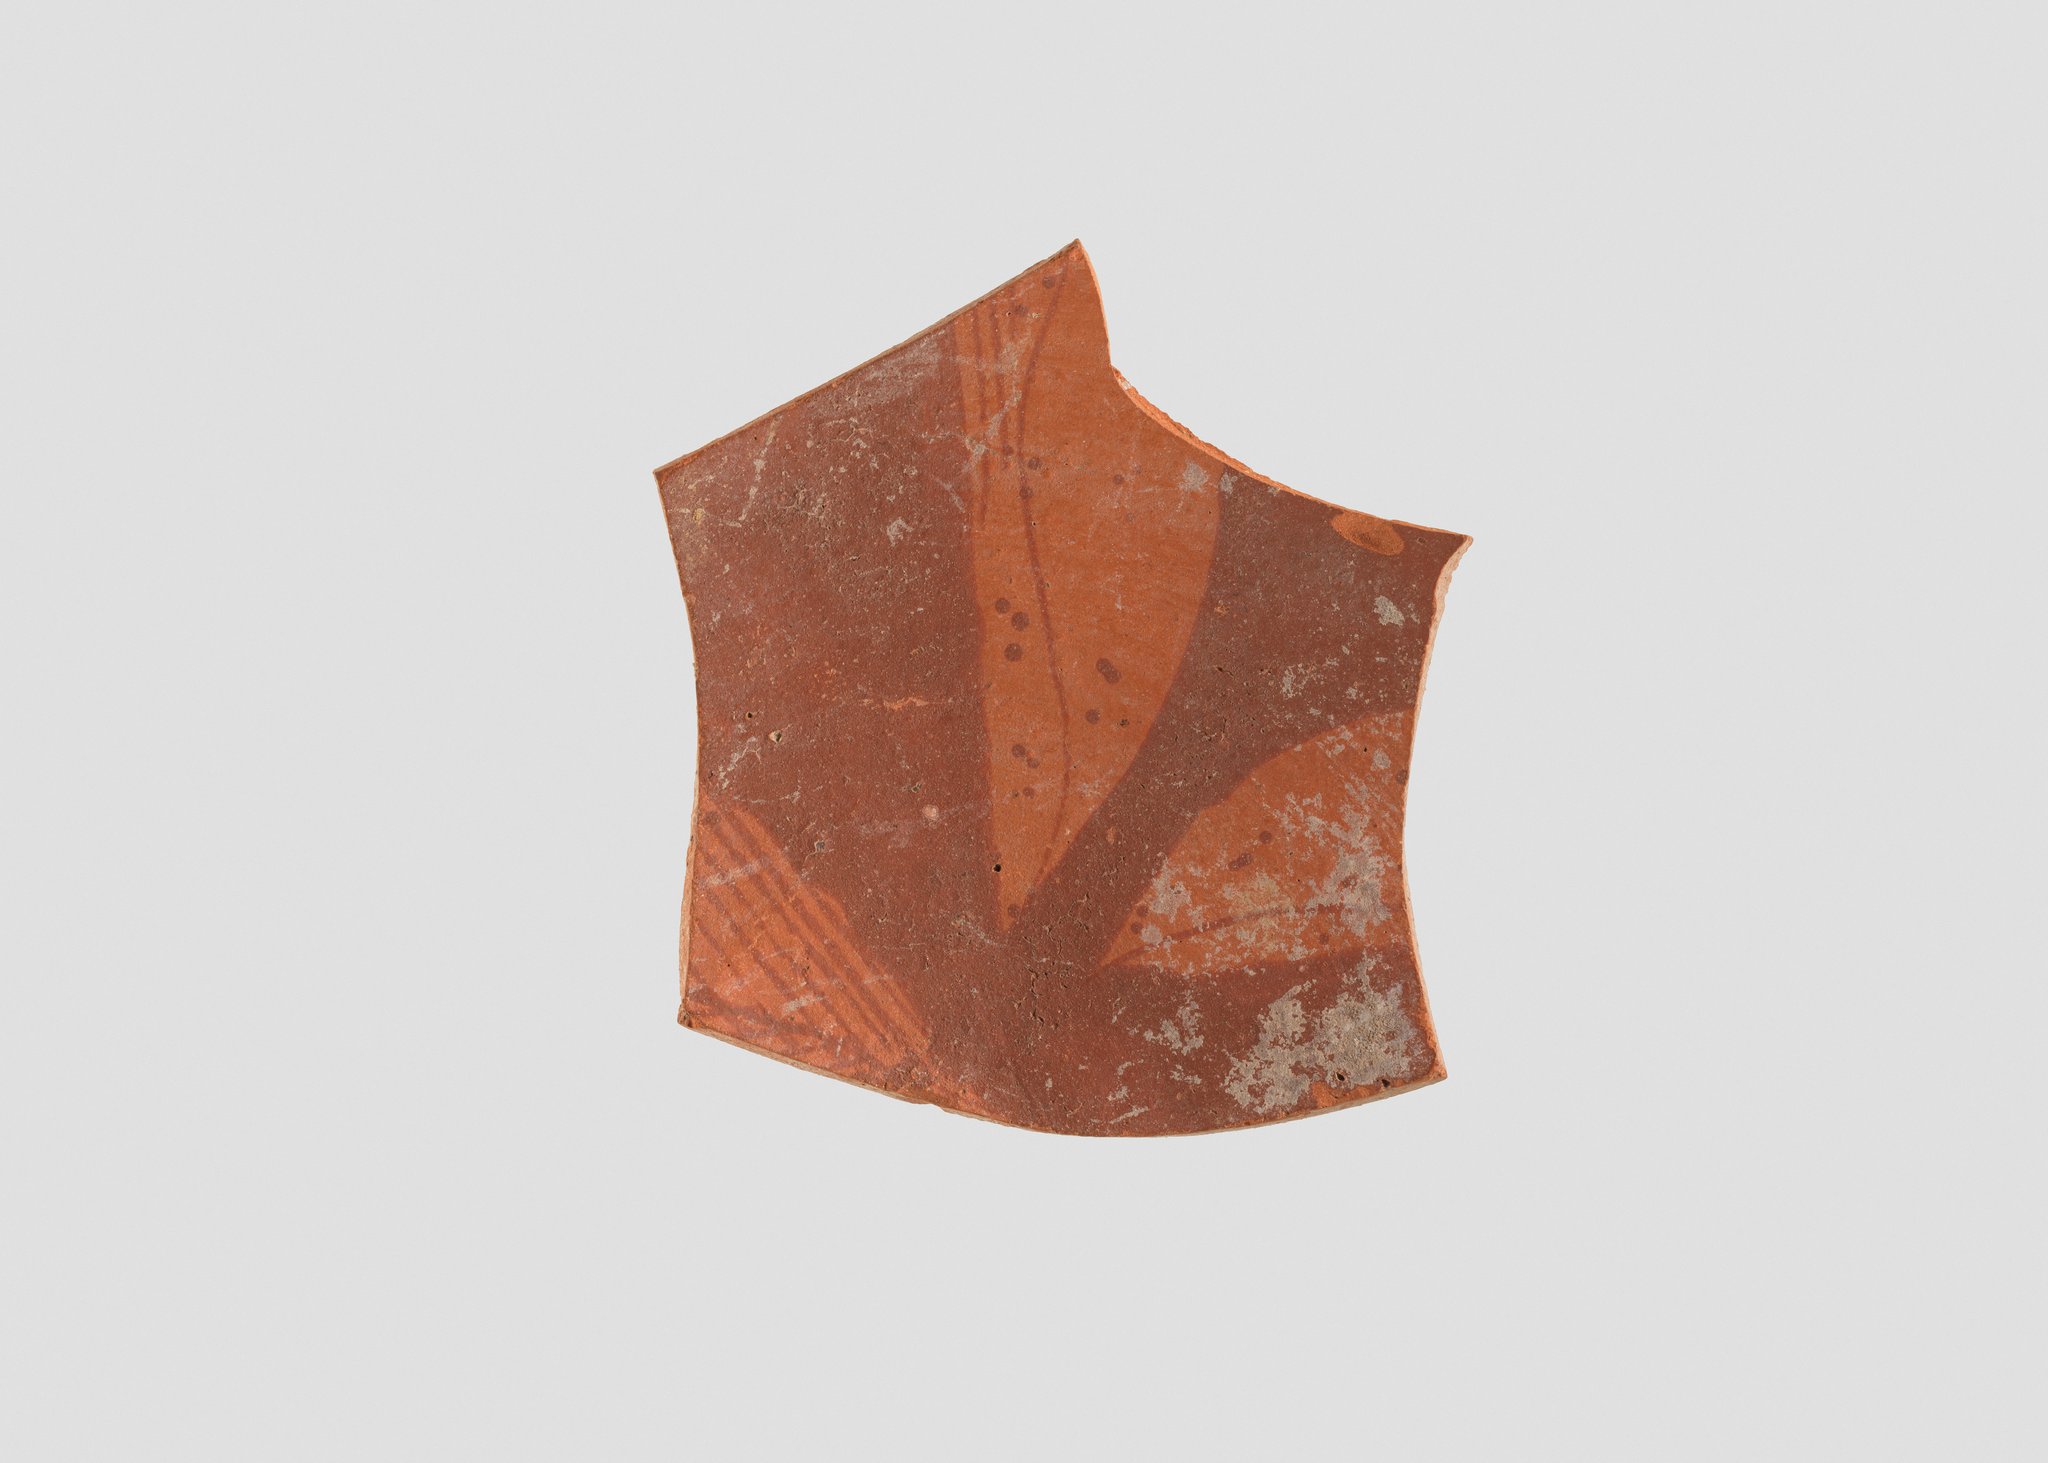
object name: sherd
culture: nabataean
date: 1-100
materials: ceramic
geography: levant